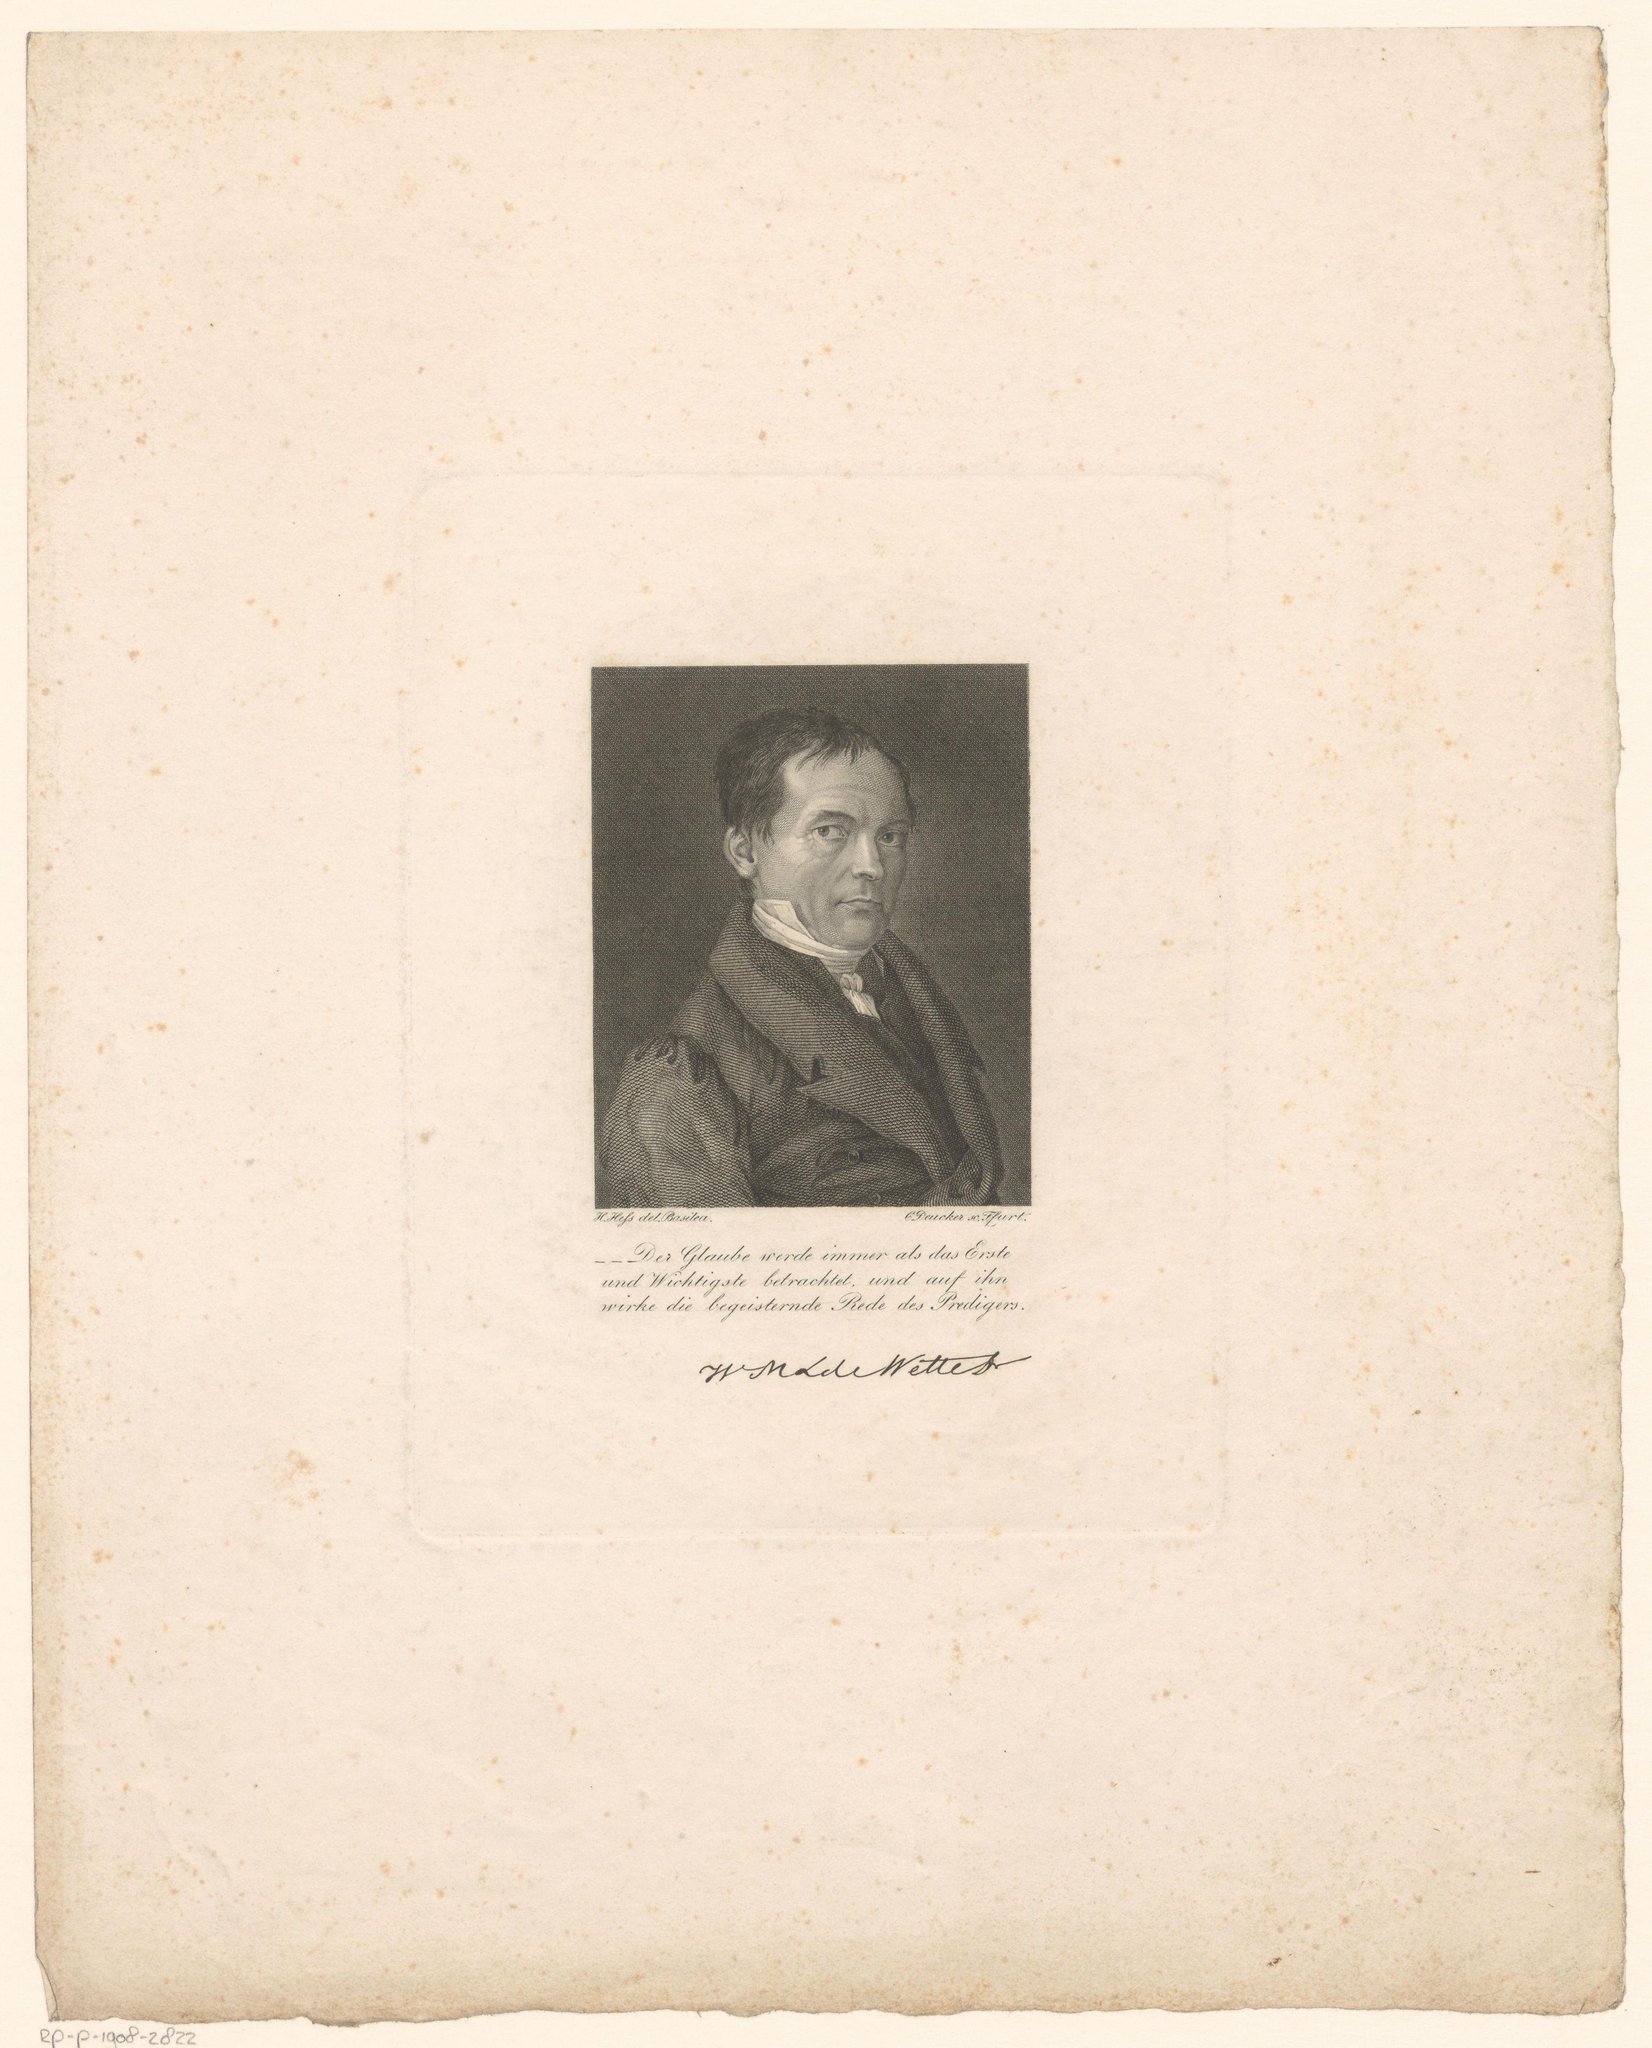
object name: print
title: Portret van Wilhelm Martin Leberecht de Wette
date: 1811-1863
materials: paper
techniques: engraving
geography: frankfurt am main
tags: historical persons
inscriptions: collector's mark: Lugt 2228